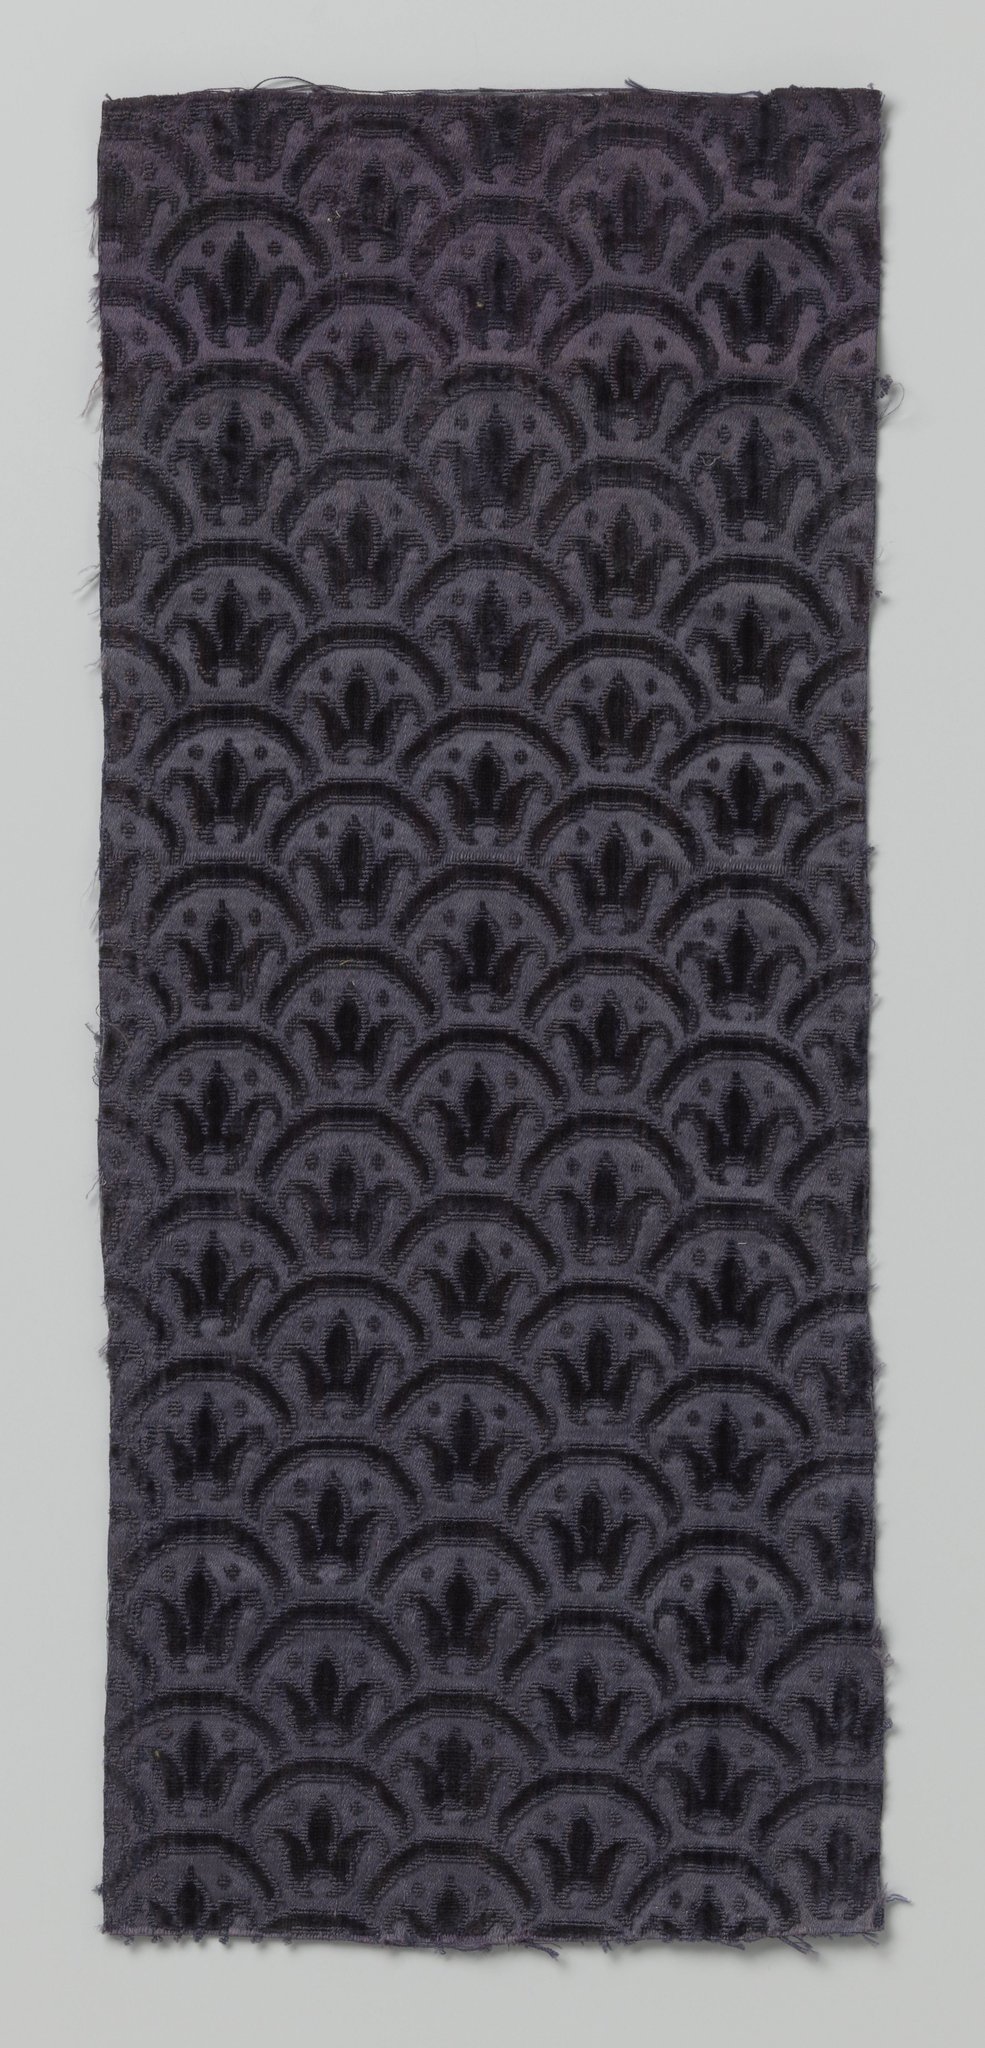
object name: zijdefluweel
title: Fragment paars fluweel met palmetten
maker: Anonymous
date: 1550-1650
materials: ciselé velvet, textile, silk, velvet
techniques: weave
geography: europe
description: Een fragment van een paars fluweel. De tekening in geschoren en getrokken pool vertoont schubsgewiijs geplaatste halve cirkels, waartussen palmetten. Opmerking: Onder het 5e rapport van boven rechts een weeffout.